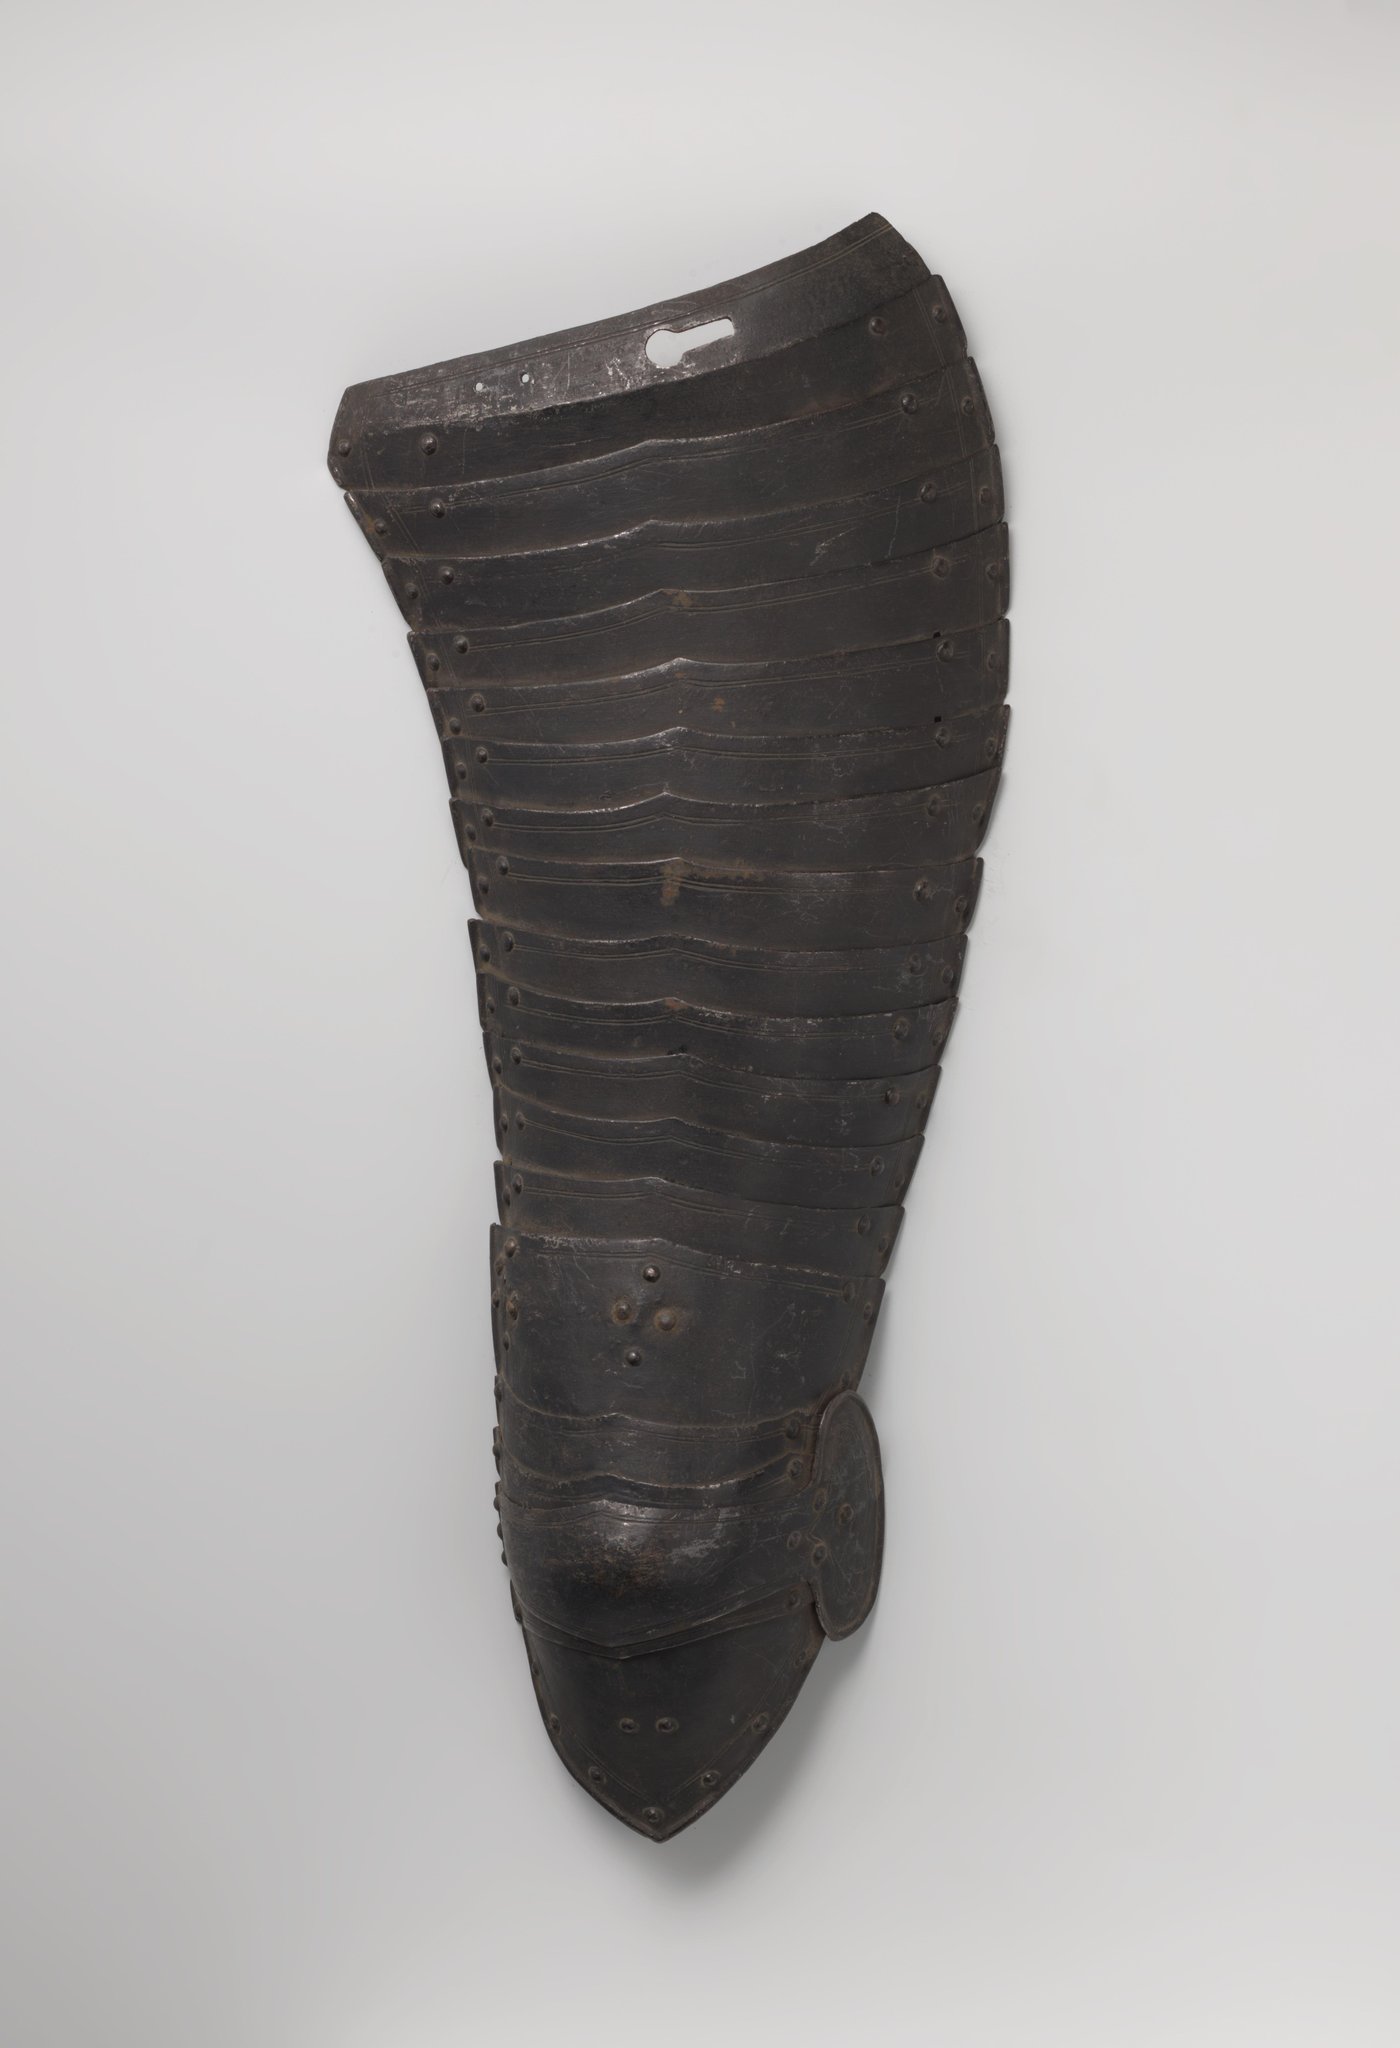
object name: dijbeenplaat, dijstuk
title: Dijstuk links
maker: Anonymous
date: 1599-1699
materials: iron, leather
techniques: forging, striking, tanning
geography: europe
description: Dijstuk links, ijzer, zwart, gearticuleerd. Aan de bovenkant van het dijkstuk een horizontaal bevestiginsgat. Het dijkstuk is aan beide zijkanten op iedere strook vastgeklonken met twee zwarte klinknagels. De knieplaat bestaat uit een brede strook welke aan de zijkant een ovale plaat heeft. Onder deze strook een driehoekige plaat met de punt naar onderen gericht. Binnenzijde is zwart geverfd. Twee stroken met leer in het midden en aan linkerzijde geklonken.